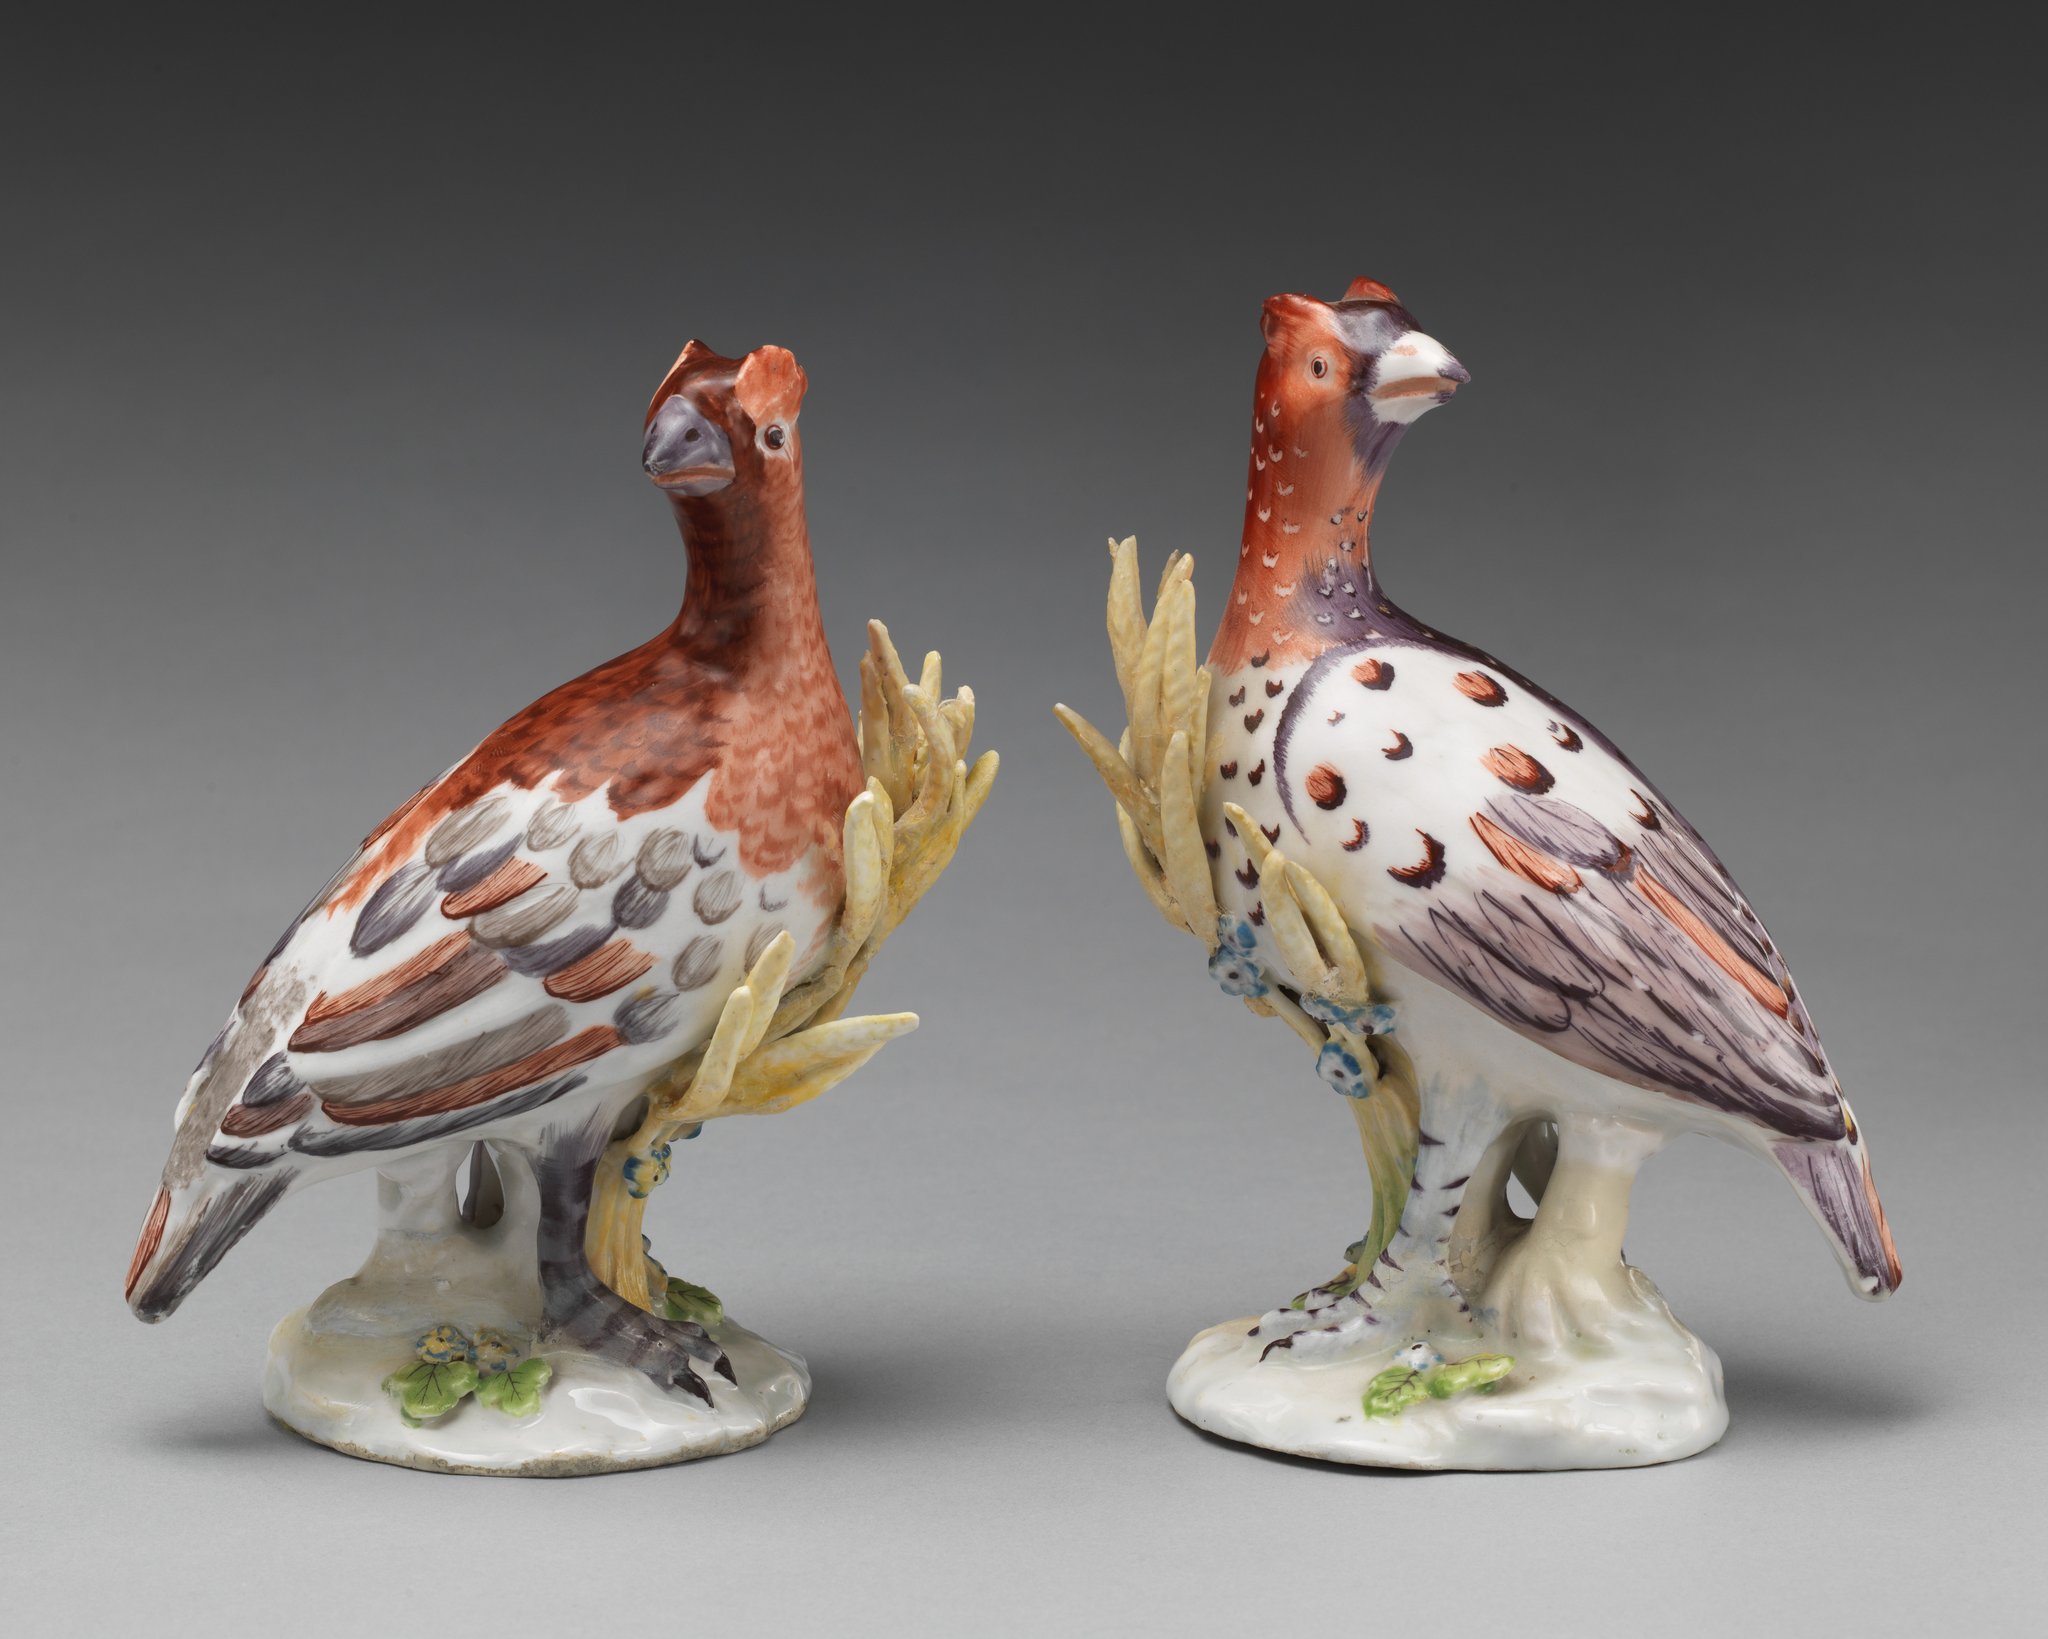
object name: figure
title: Pair of partridges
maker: chelsea porcelain manufactory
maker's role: factory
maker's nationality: british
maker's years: 1744-1784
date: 1750-1752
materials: soft paste porcelain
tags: birds